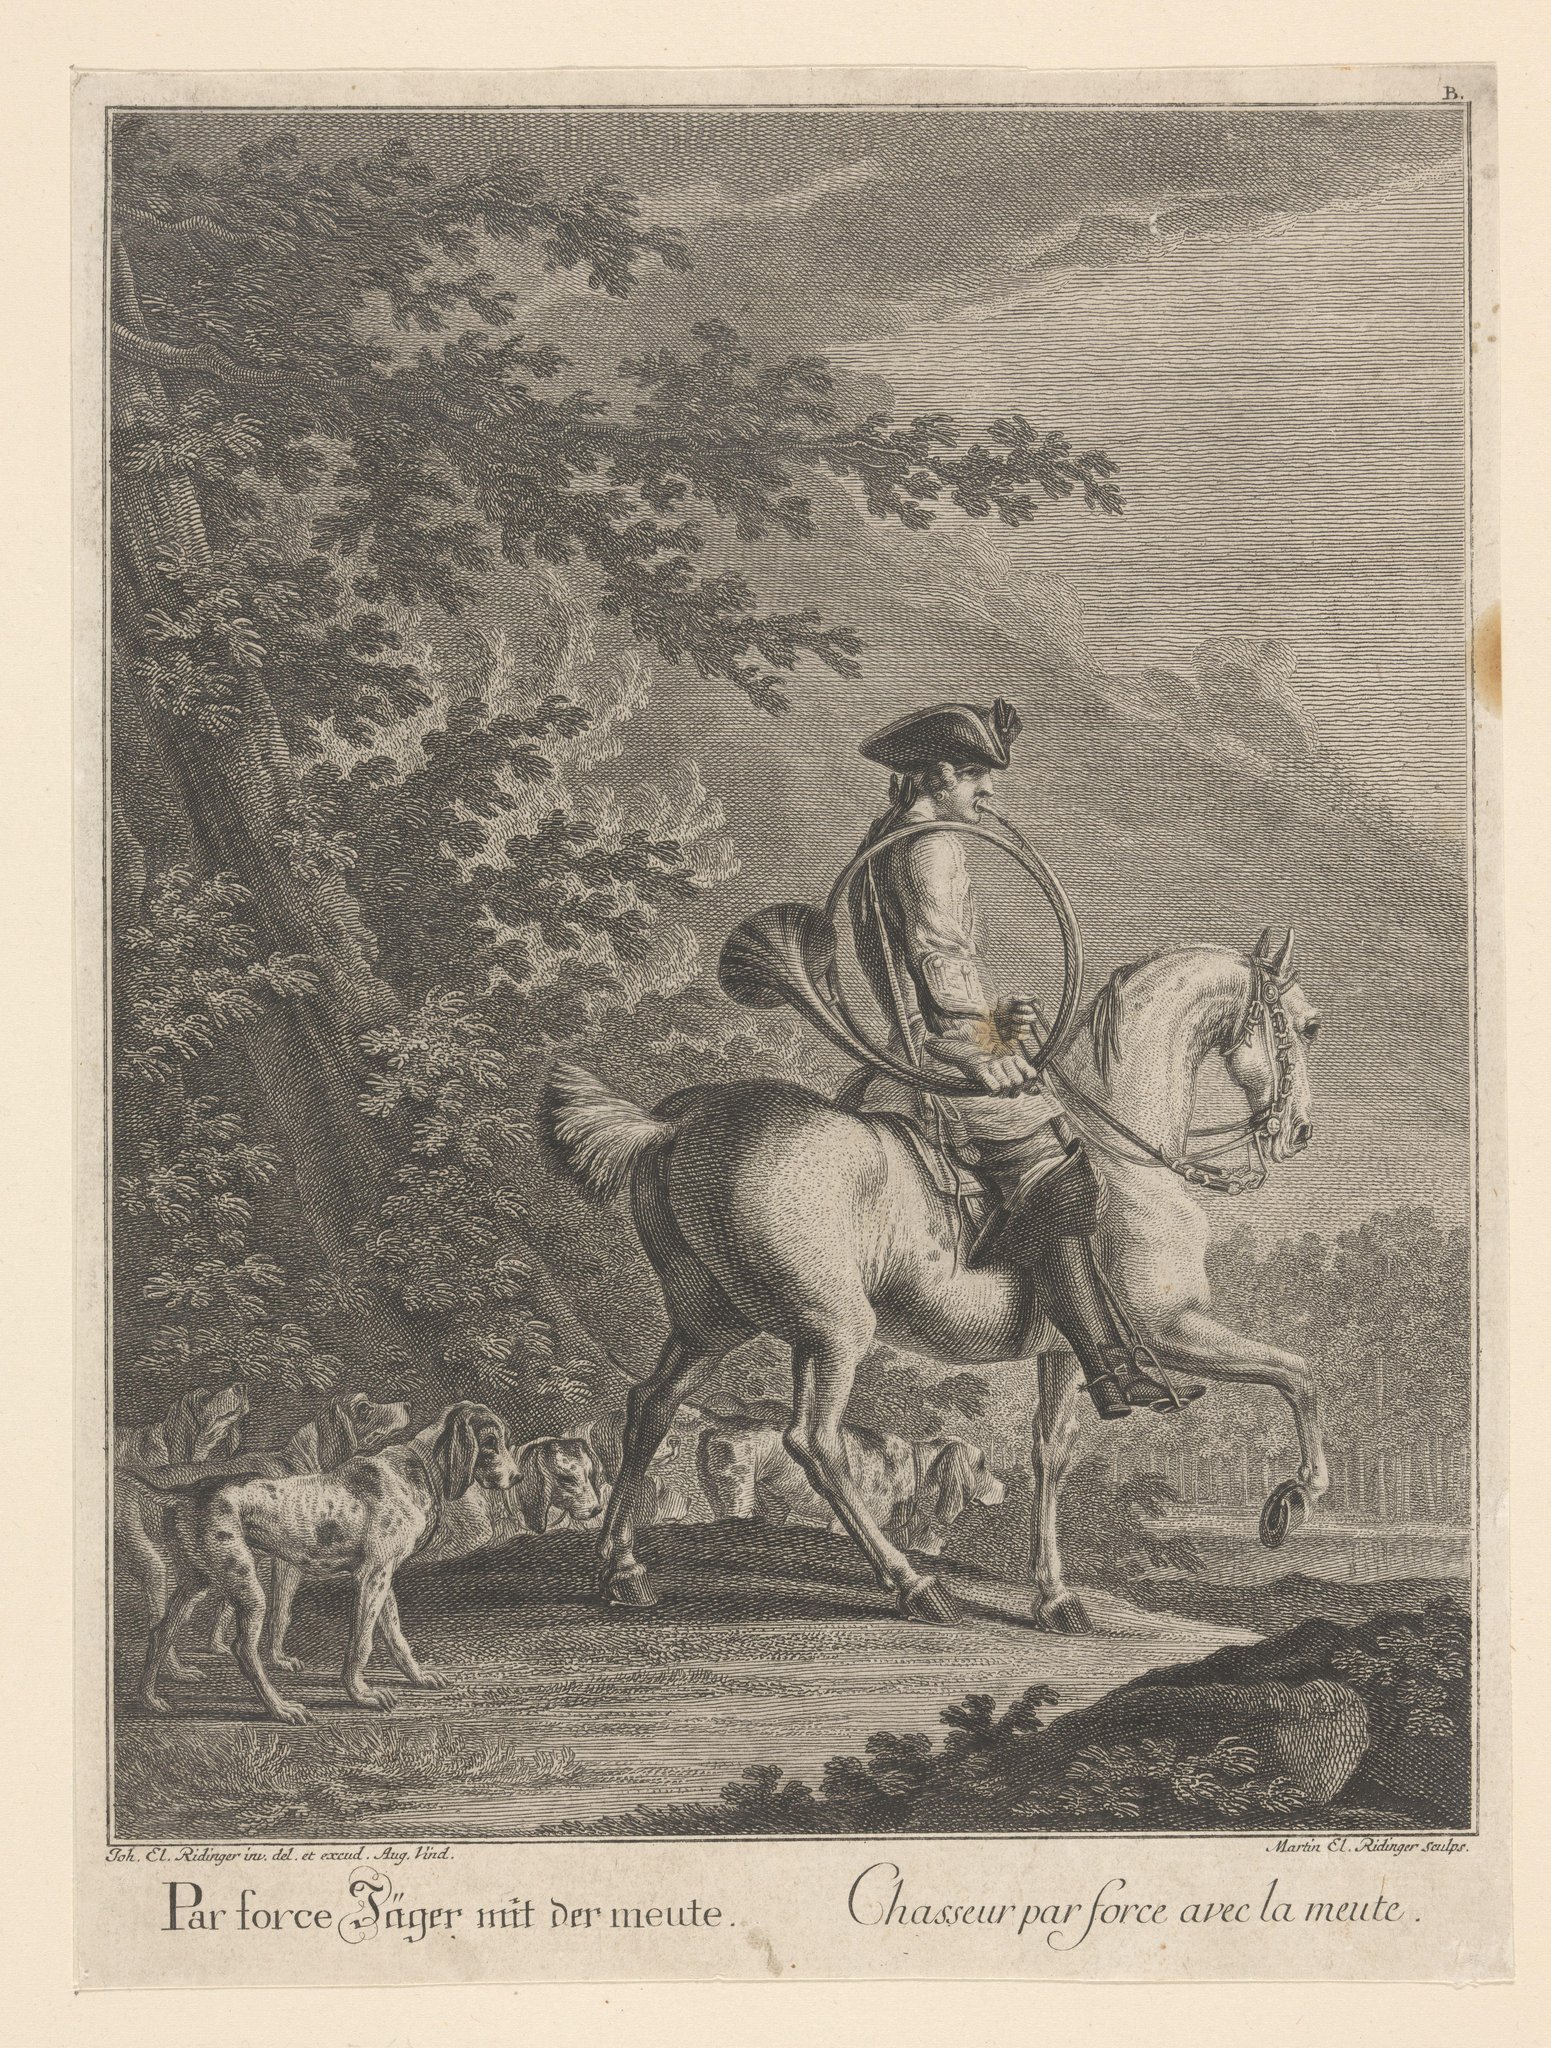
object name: print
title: Jager te paard met jachthonden blaast op een hoorn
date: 1740-1780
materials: paper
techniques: etching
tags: riding a horse, ass, or mule; rider, horseman, hunting dogs, hunter, blowing the hunting horn